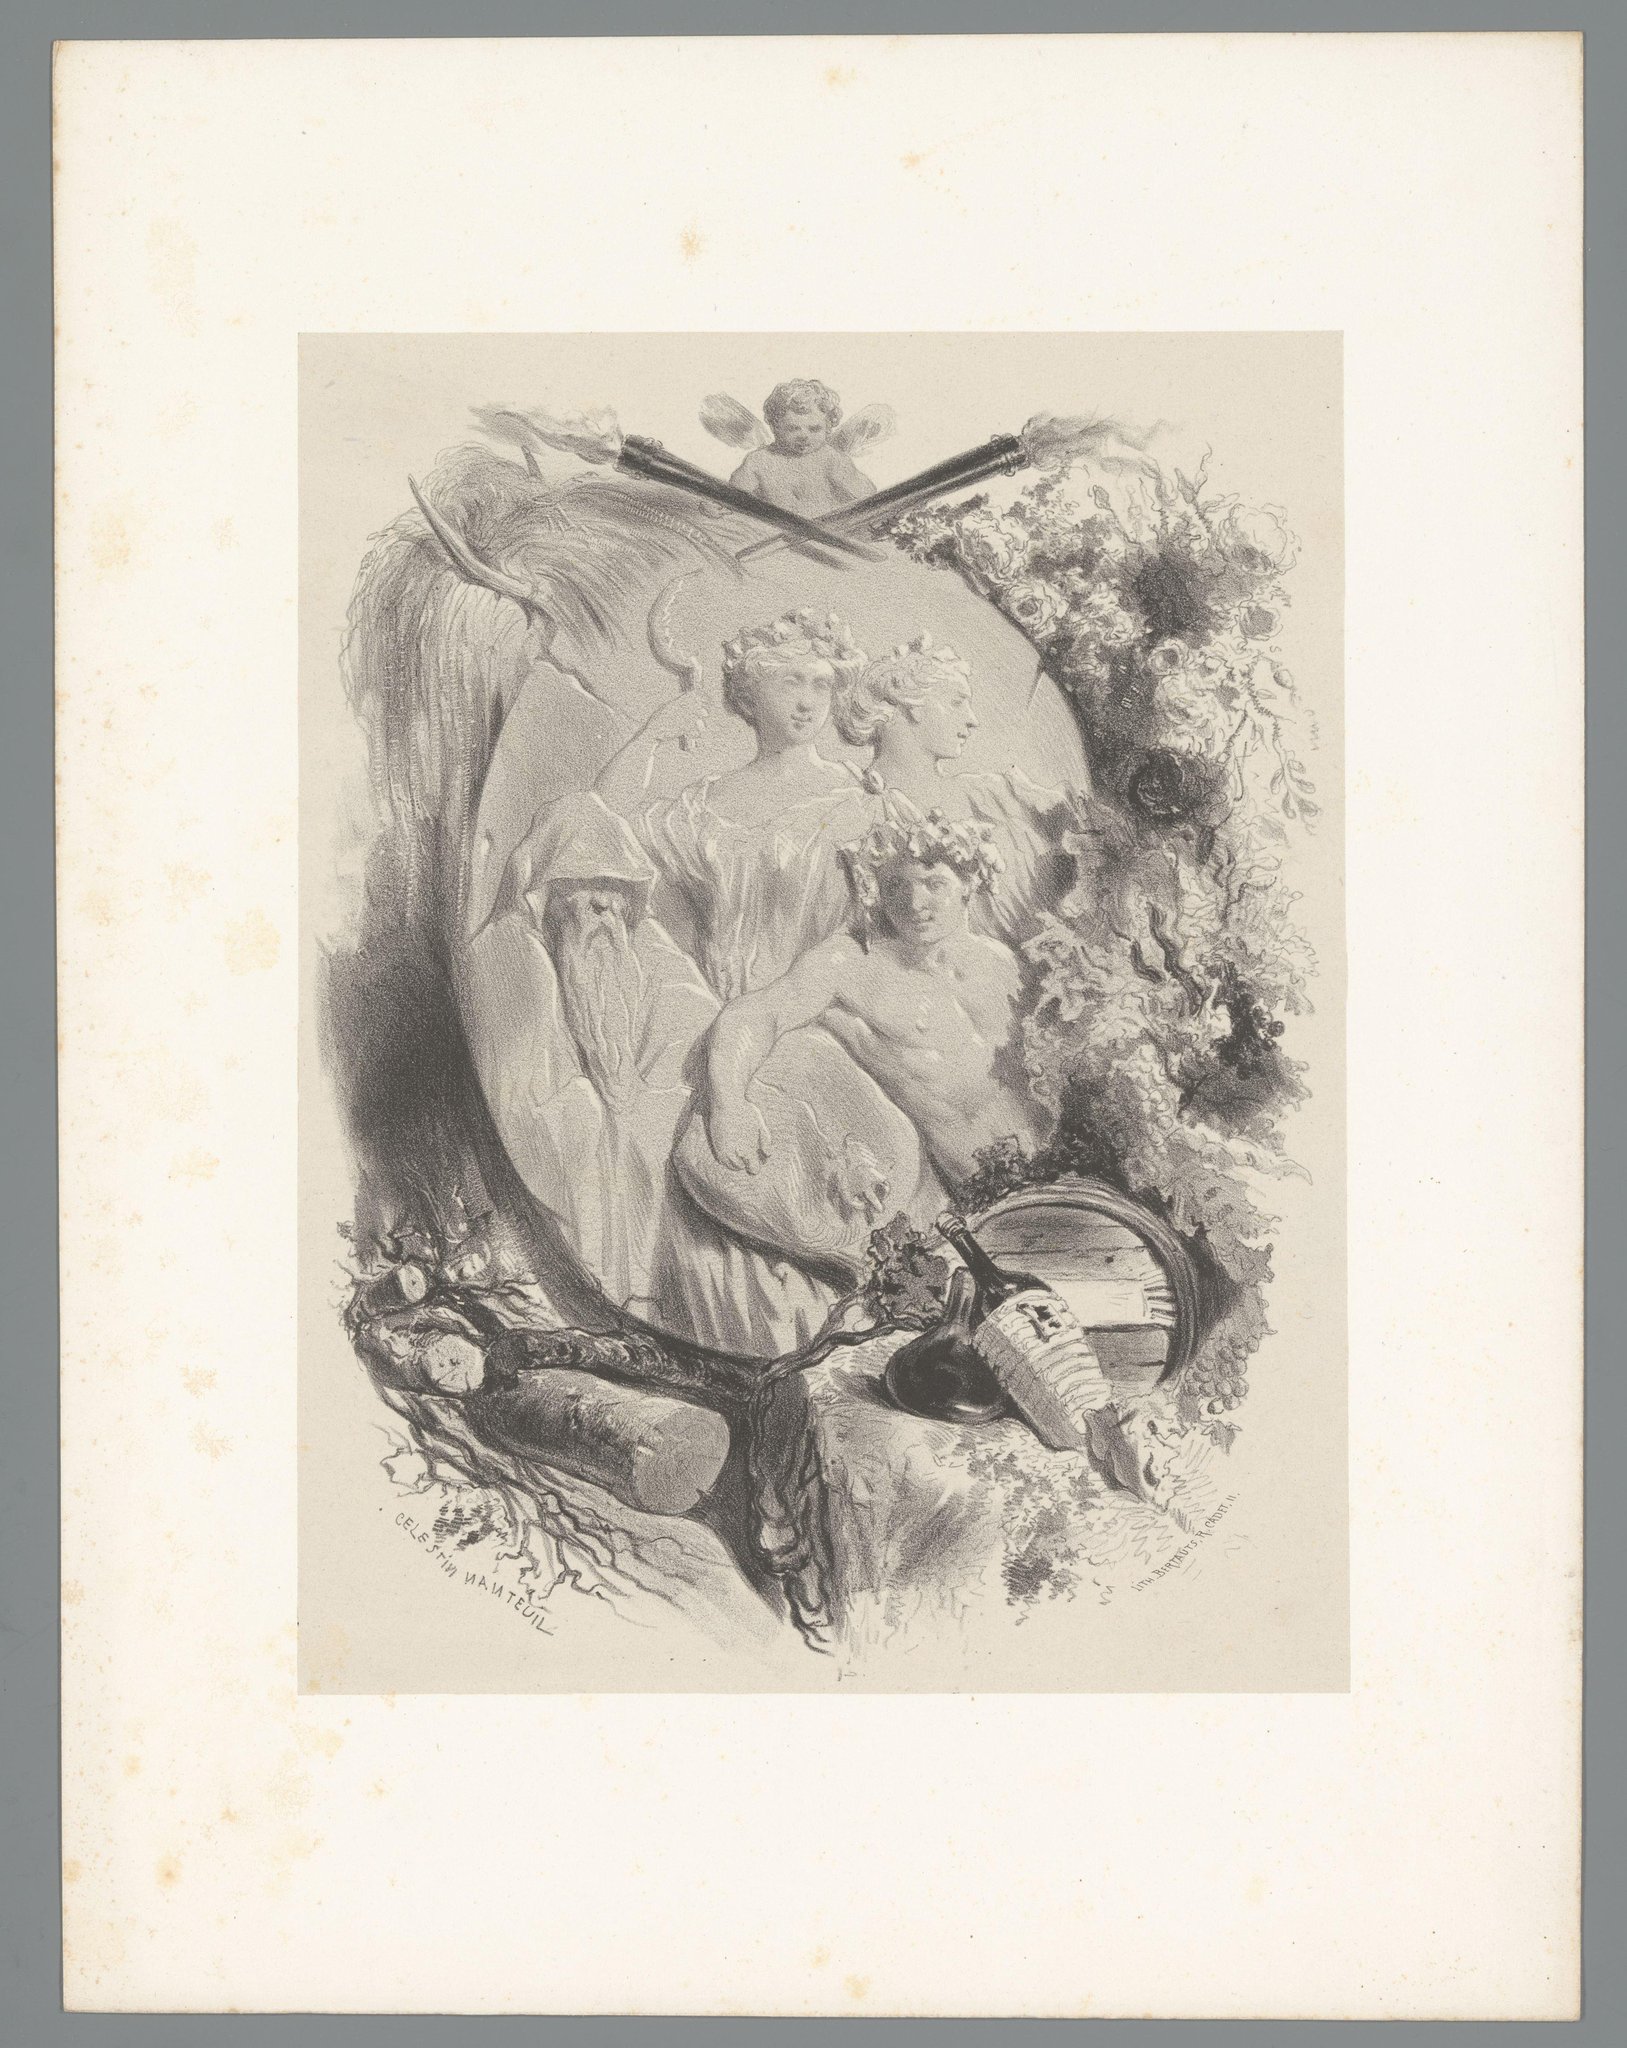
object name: print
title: Ovaal reliëf met onder anderen Ceres en Bacchus, omringd door een putto met fakkels, een wijnvat, flessen wijn en bloemen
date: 1851-1865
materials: paper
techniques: lithograph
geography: paris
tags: agricultural implements: scythe, torch, wooden container: barrel, cask, bucket, (story of) bacchus (dionysus), liber, cupids: 'amores', 'amoretti', 'putti', ceres, patroness of agriculture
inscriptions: collector's mark: Lugt 964